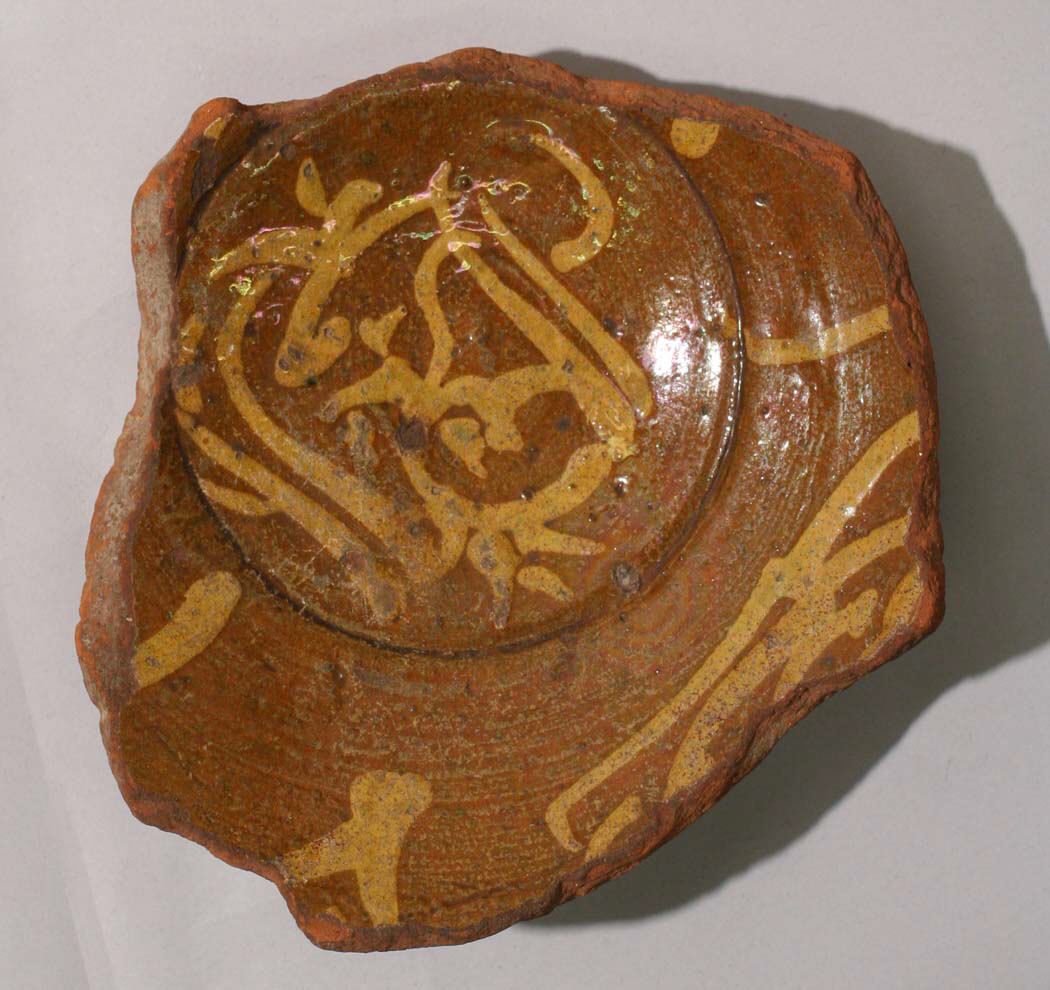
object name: fragment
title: Fragment of a Bowl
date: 1301-1500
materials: earthenware, glaze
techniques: painting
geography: egypt